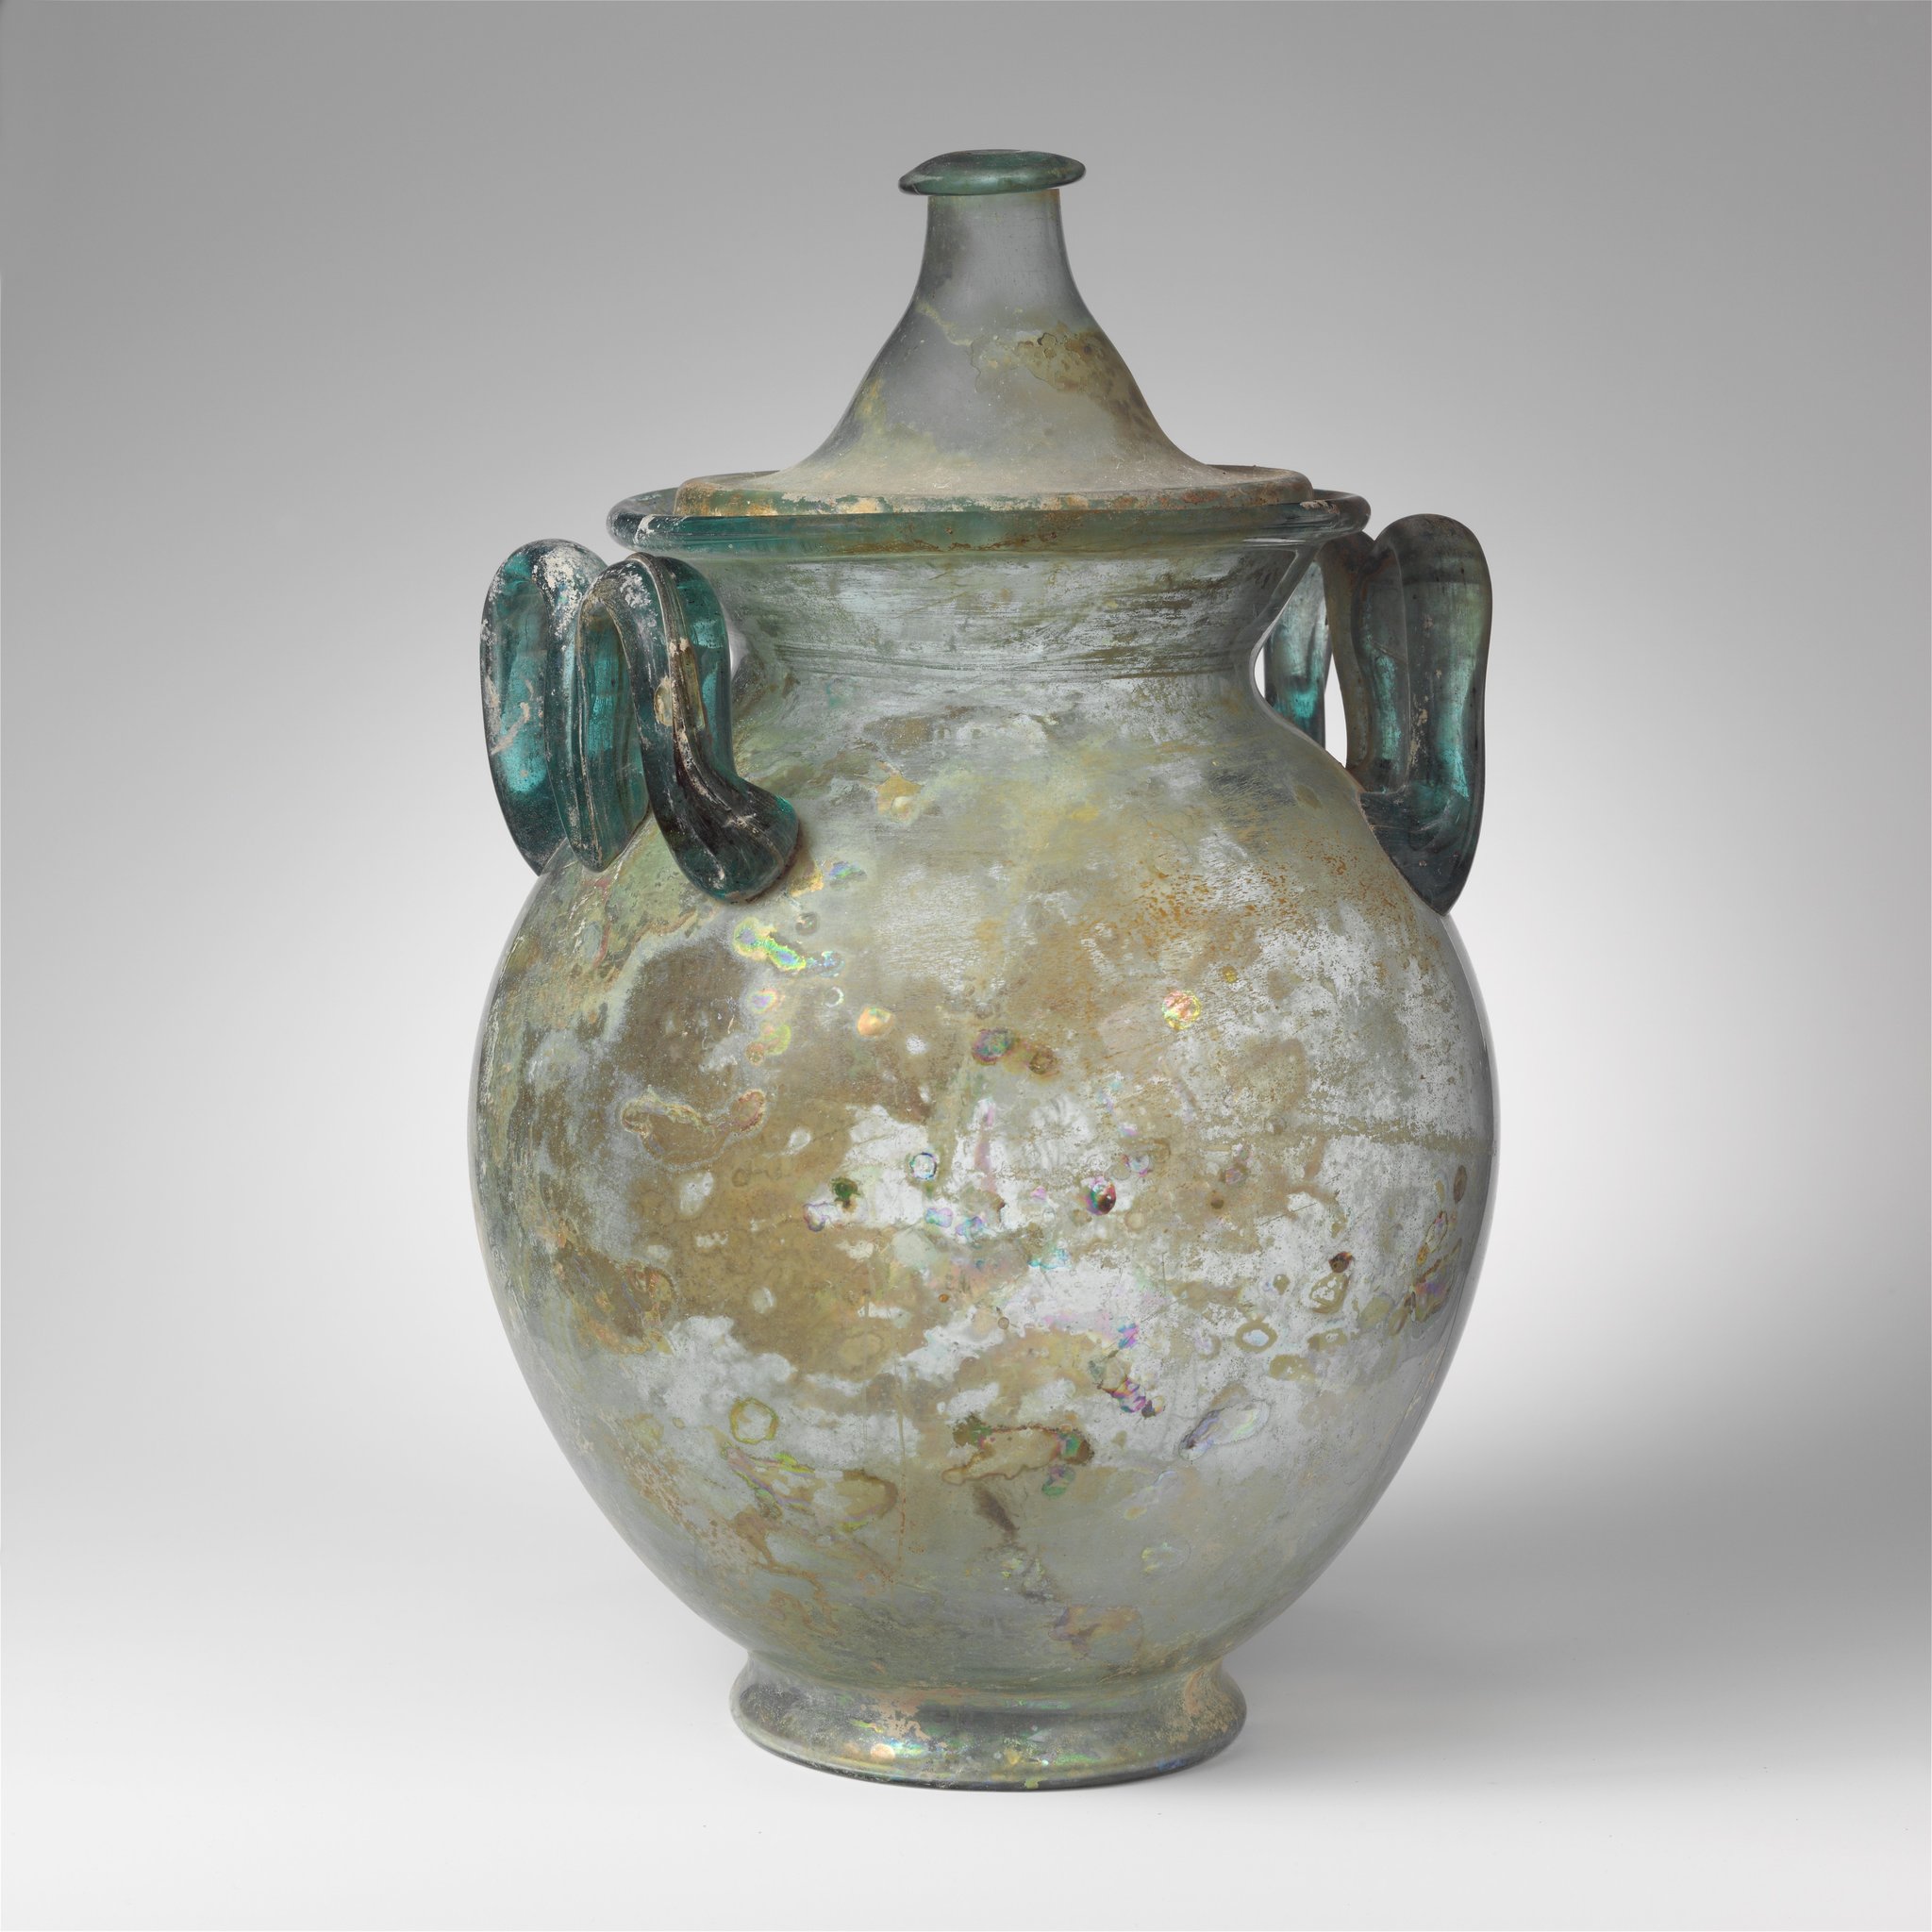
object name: urn with two handle and lid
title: Glass cinerary urn with lid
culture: roman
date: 34-200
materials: glass